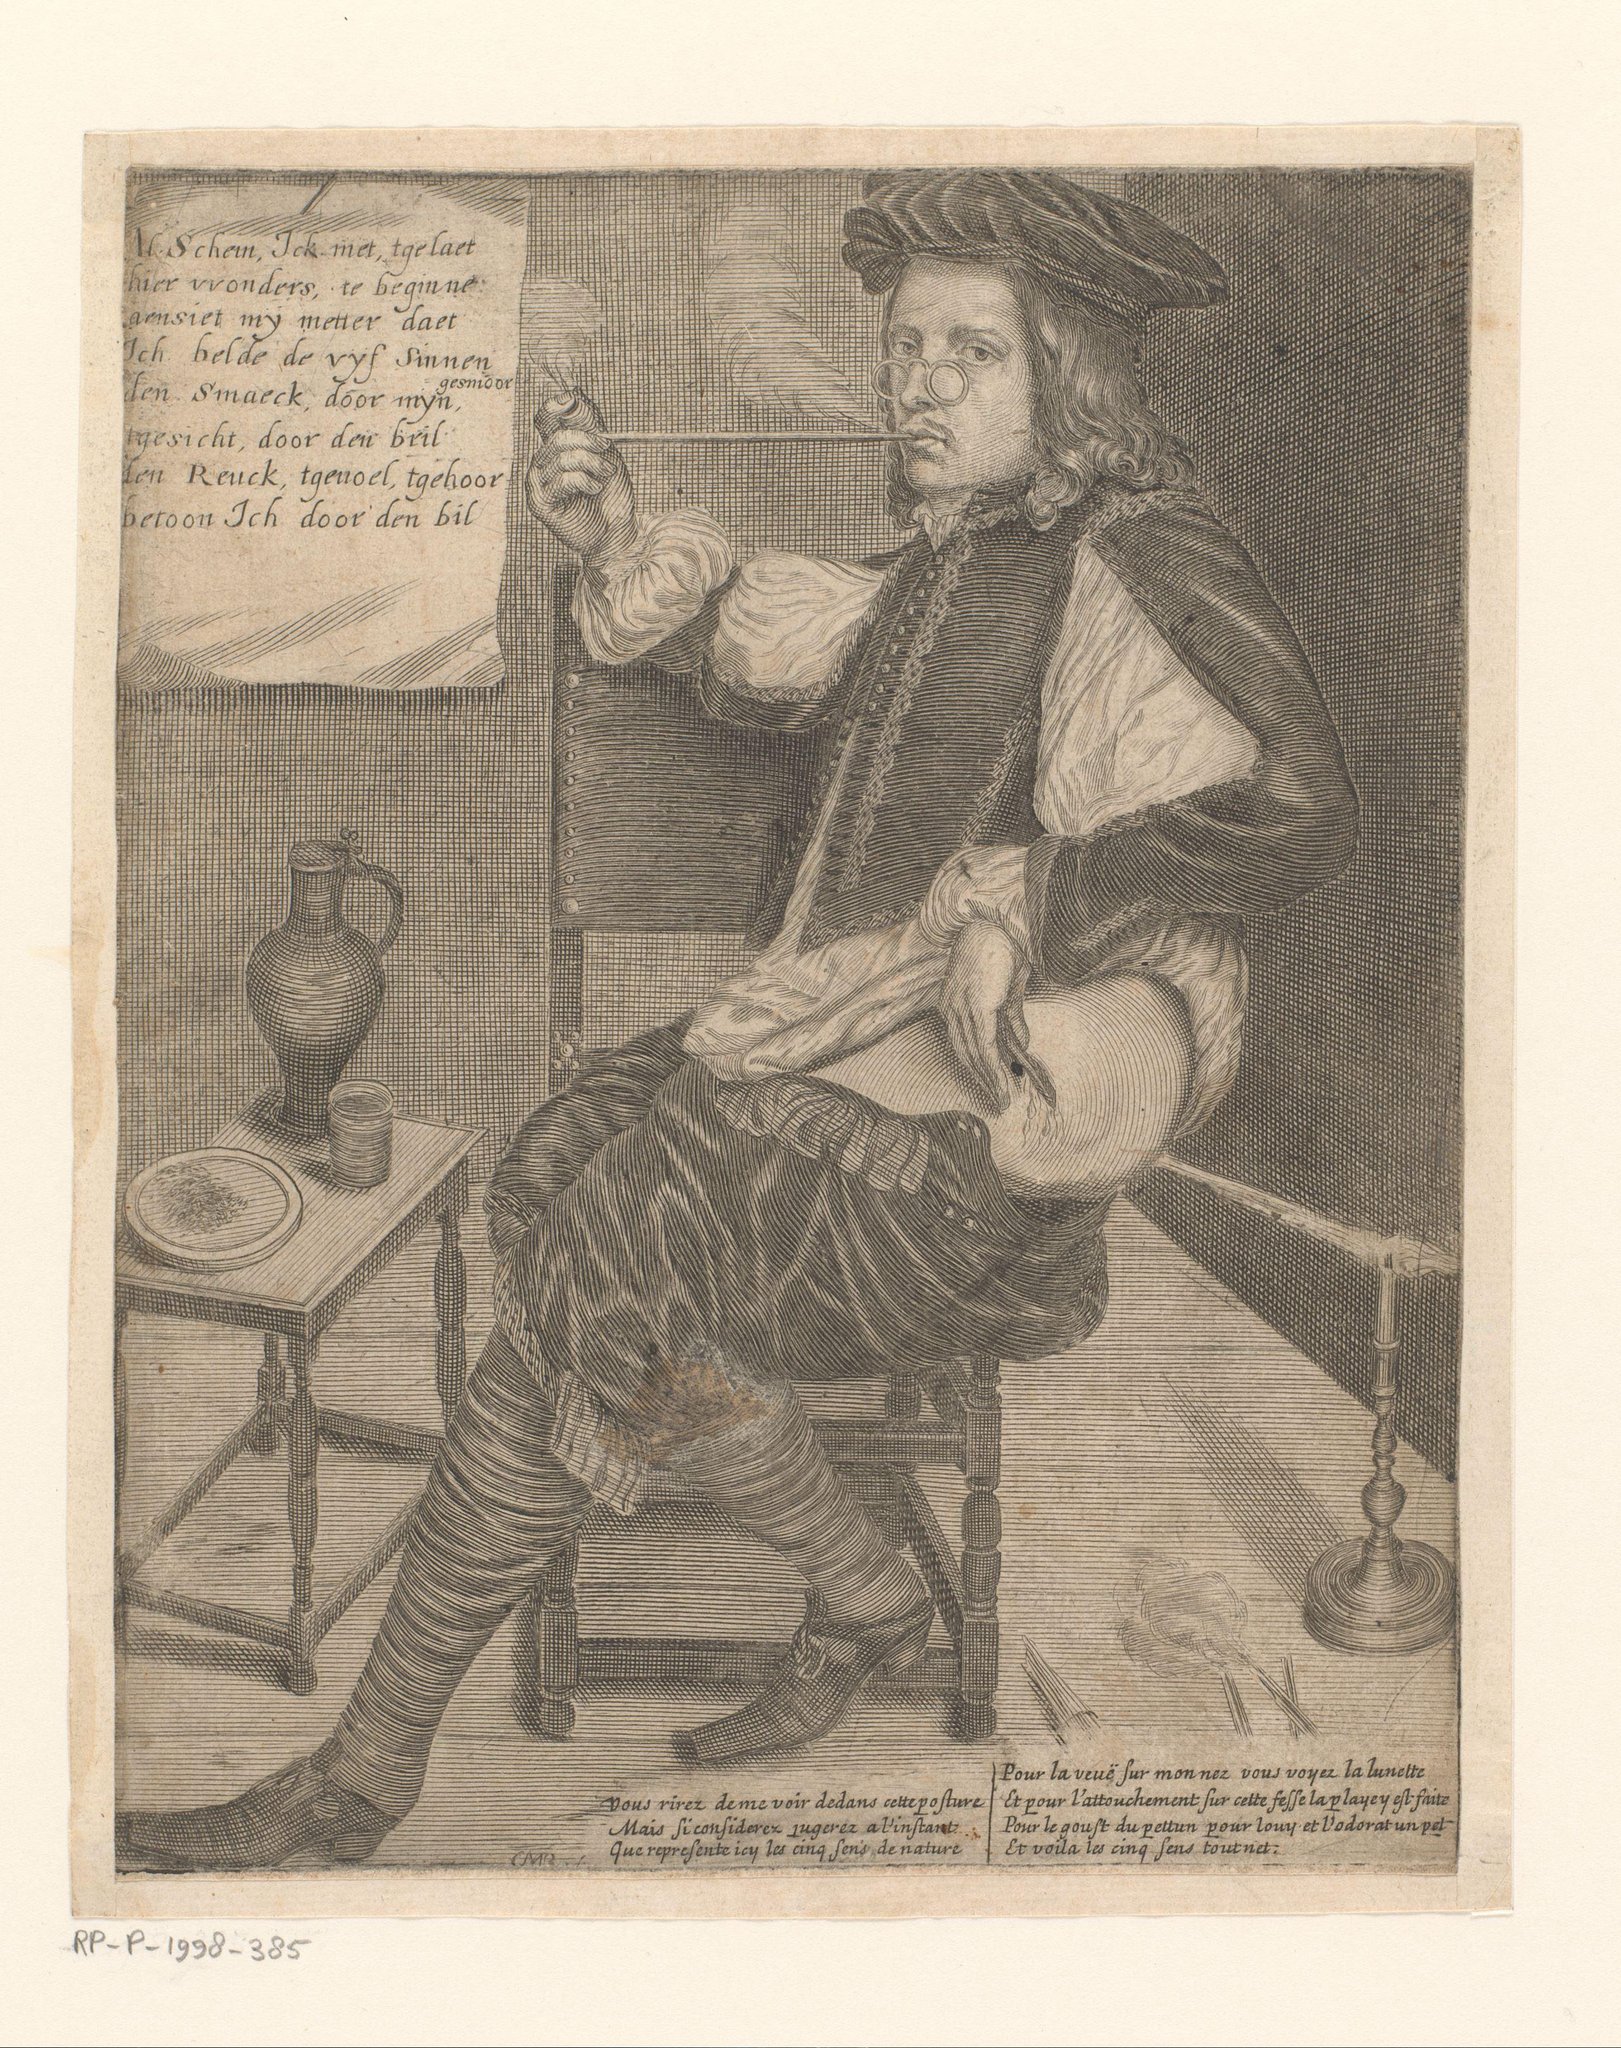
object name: print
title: De vijf zintuigen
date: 1645-1681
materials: paper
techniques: engraving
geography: france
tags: the (five) senses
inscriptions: collector's mark: Lugt 2760, poem: ‘Al Schein Ick met tgelaet / hier wonders te beginnen / aensiet mij metter daet / Ick belde de vijf Sinnen / den Smaeck, door mijn gesmoor / tgesicht, door den bril / den Reuck, tgevoel, tgehoor / betoon ick door den bil’, collector's mark: Lugt 2228, caption: ‘Vous rirez de me voir dedans cette posture...Et voila les cinq sens tout net.’, monogram: ‘CM’, collector's mark: Lugt 5101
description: Spotprent op zeventiende-eeuwse uitbeeldingen van de vijf zintuigen. Als personificatie van de vijf zintuigen een pijp rokende man (de smaak) met een bril (het gezicht) zittend op een stoel. Met een mesje snijdt hij zich in de bil (het gevoel). Tegelijkertijd laat hij een wind (de reuk en het gehoor), waarmee een brandende kaars op de grond wordt uitgeblazen. Naast hem een tafel waarop een kan, een beker en een bord. Op een vel papier links aan de muur een verklarend gedicht in het Nederlands en een vertaling in het Frans midden onder.